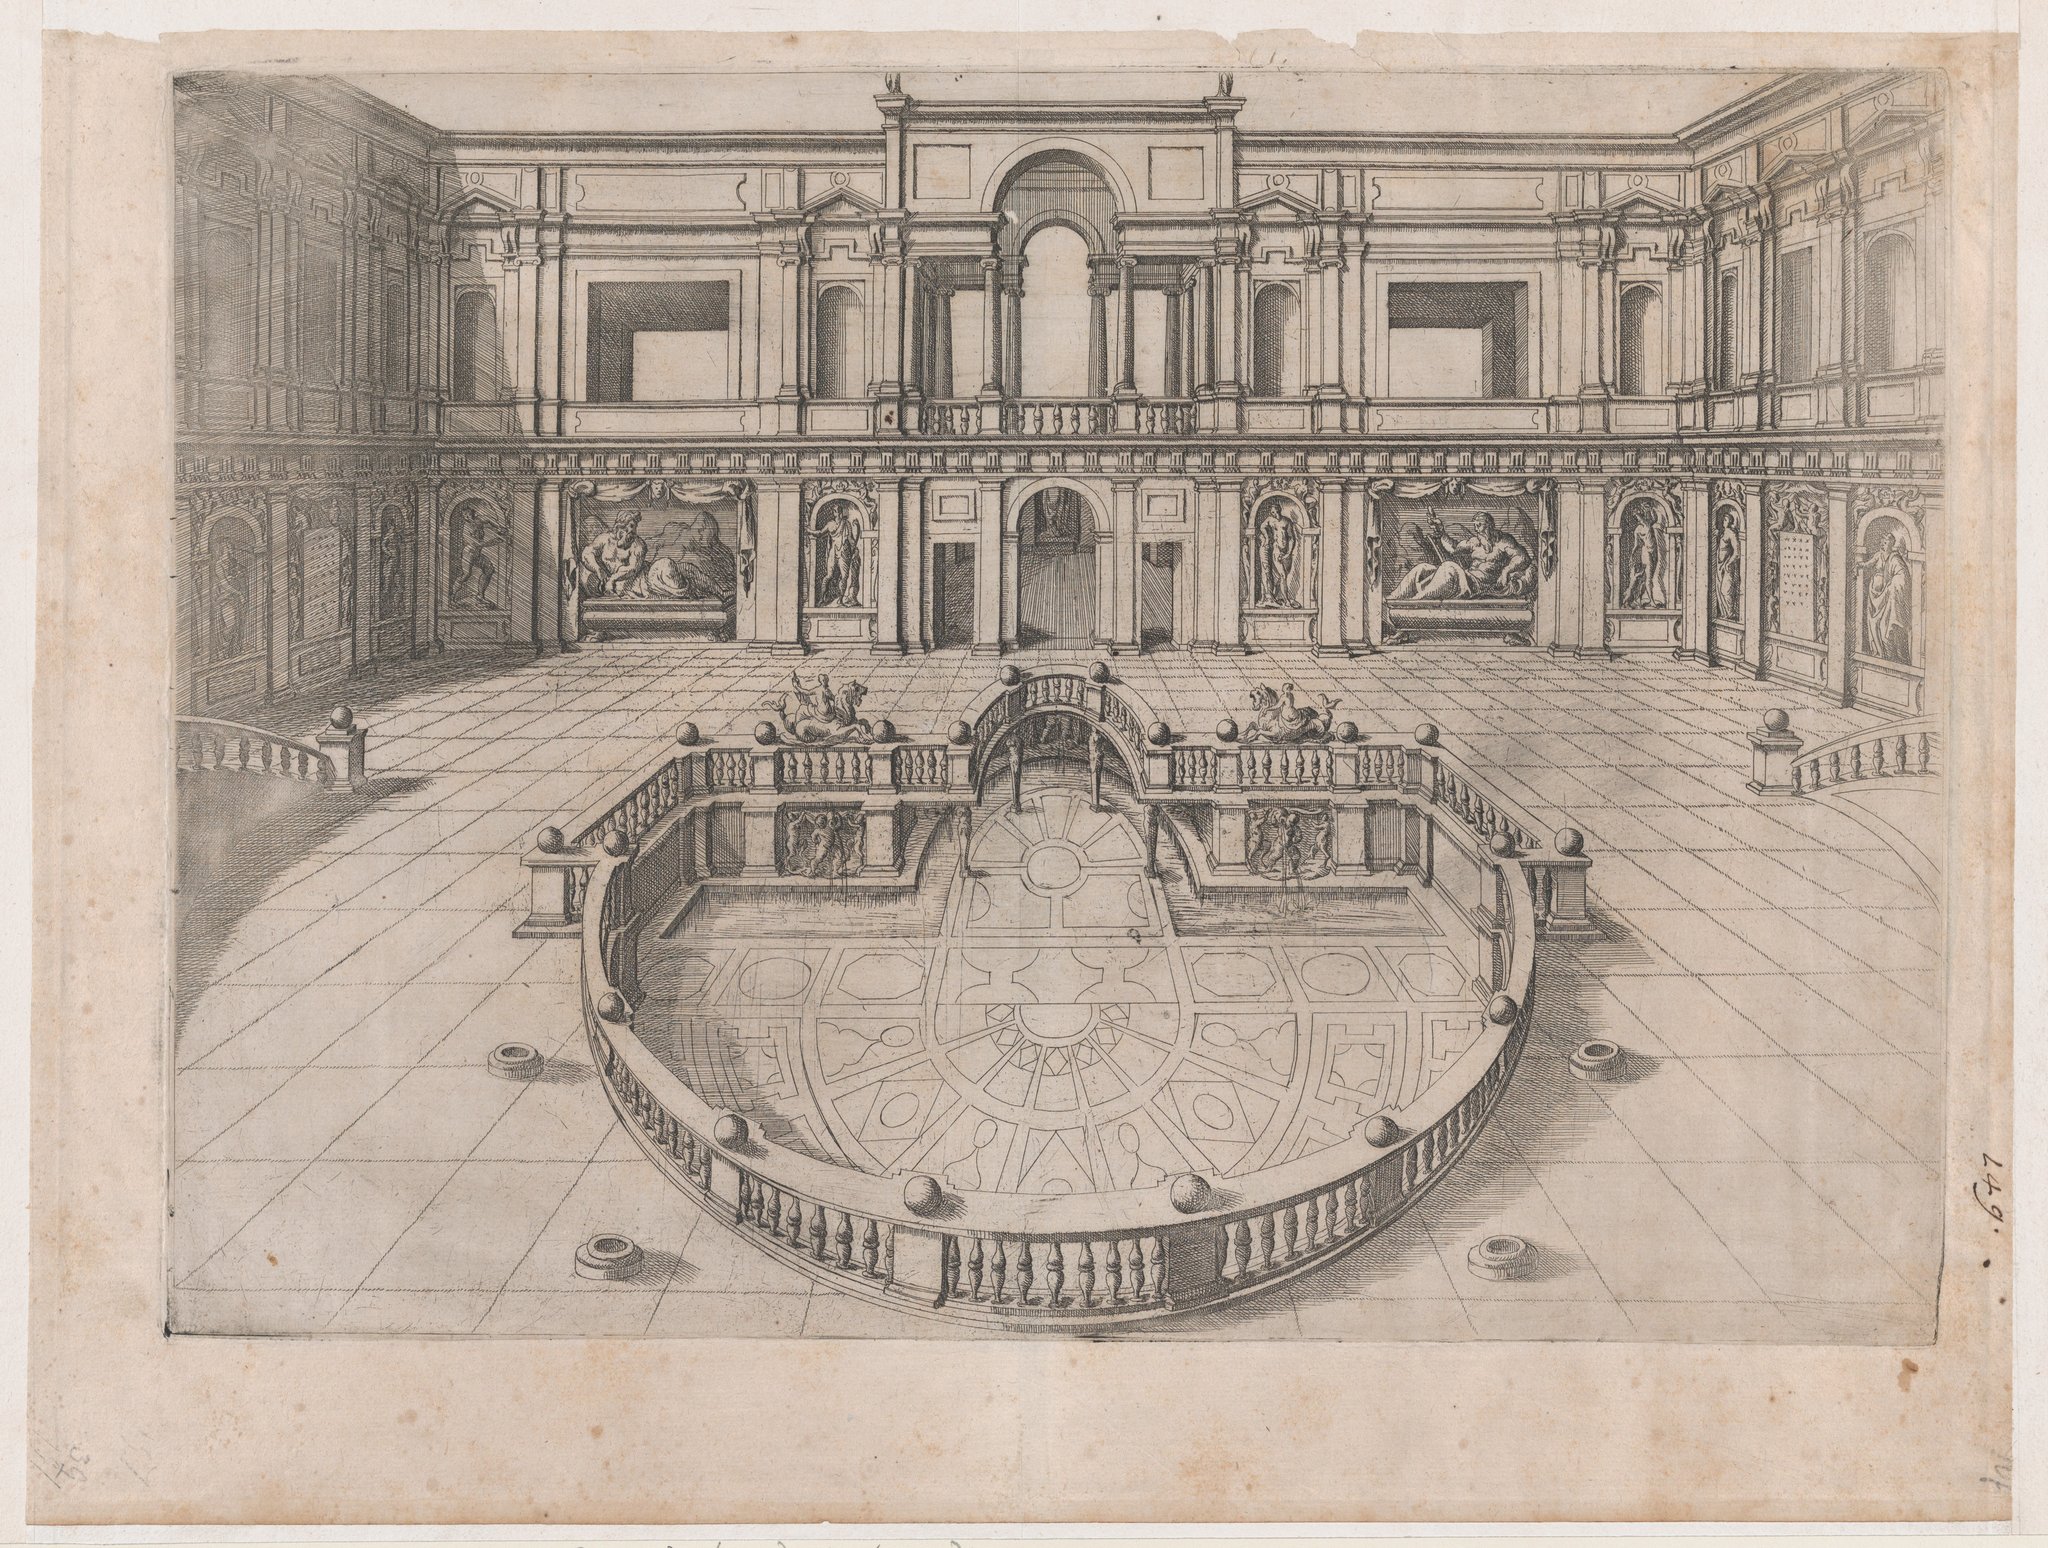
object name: print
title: Great Hall within the Villa of Pope Julius, from "Speculum Romanae Magnificentiae"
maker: Anonymous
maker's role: artist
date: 1501-1600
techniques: engraving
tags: architecture,rome